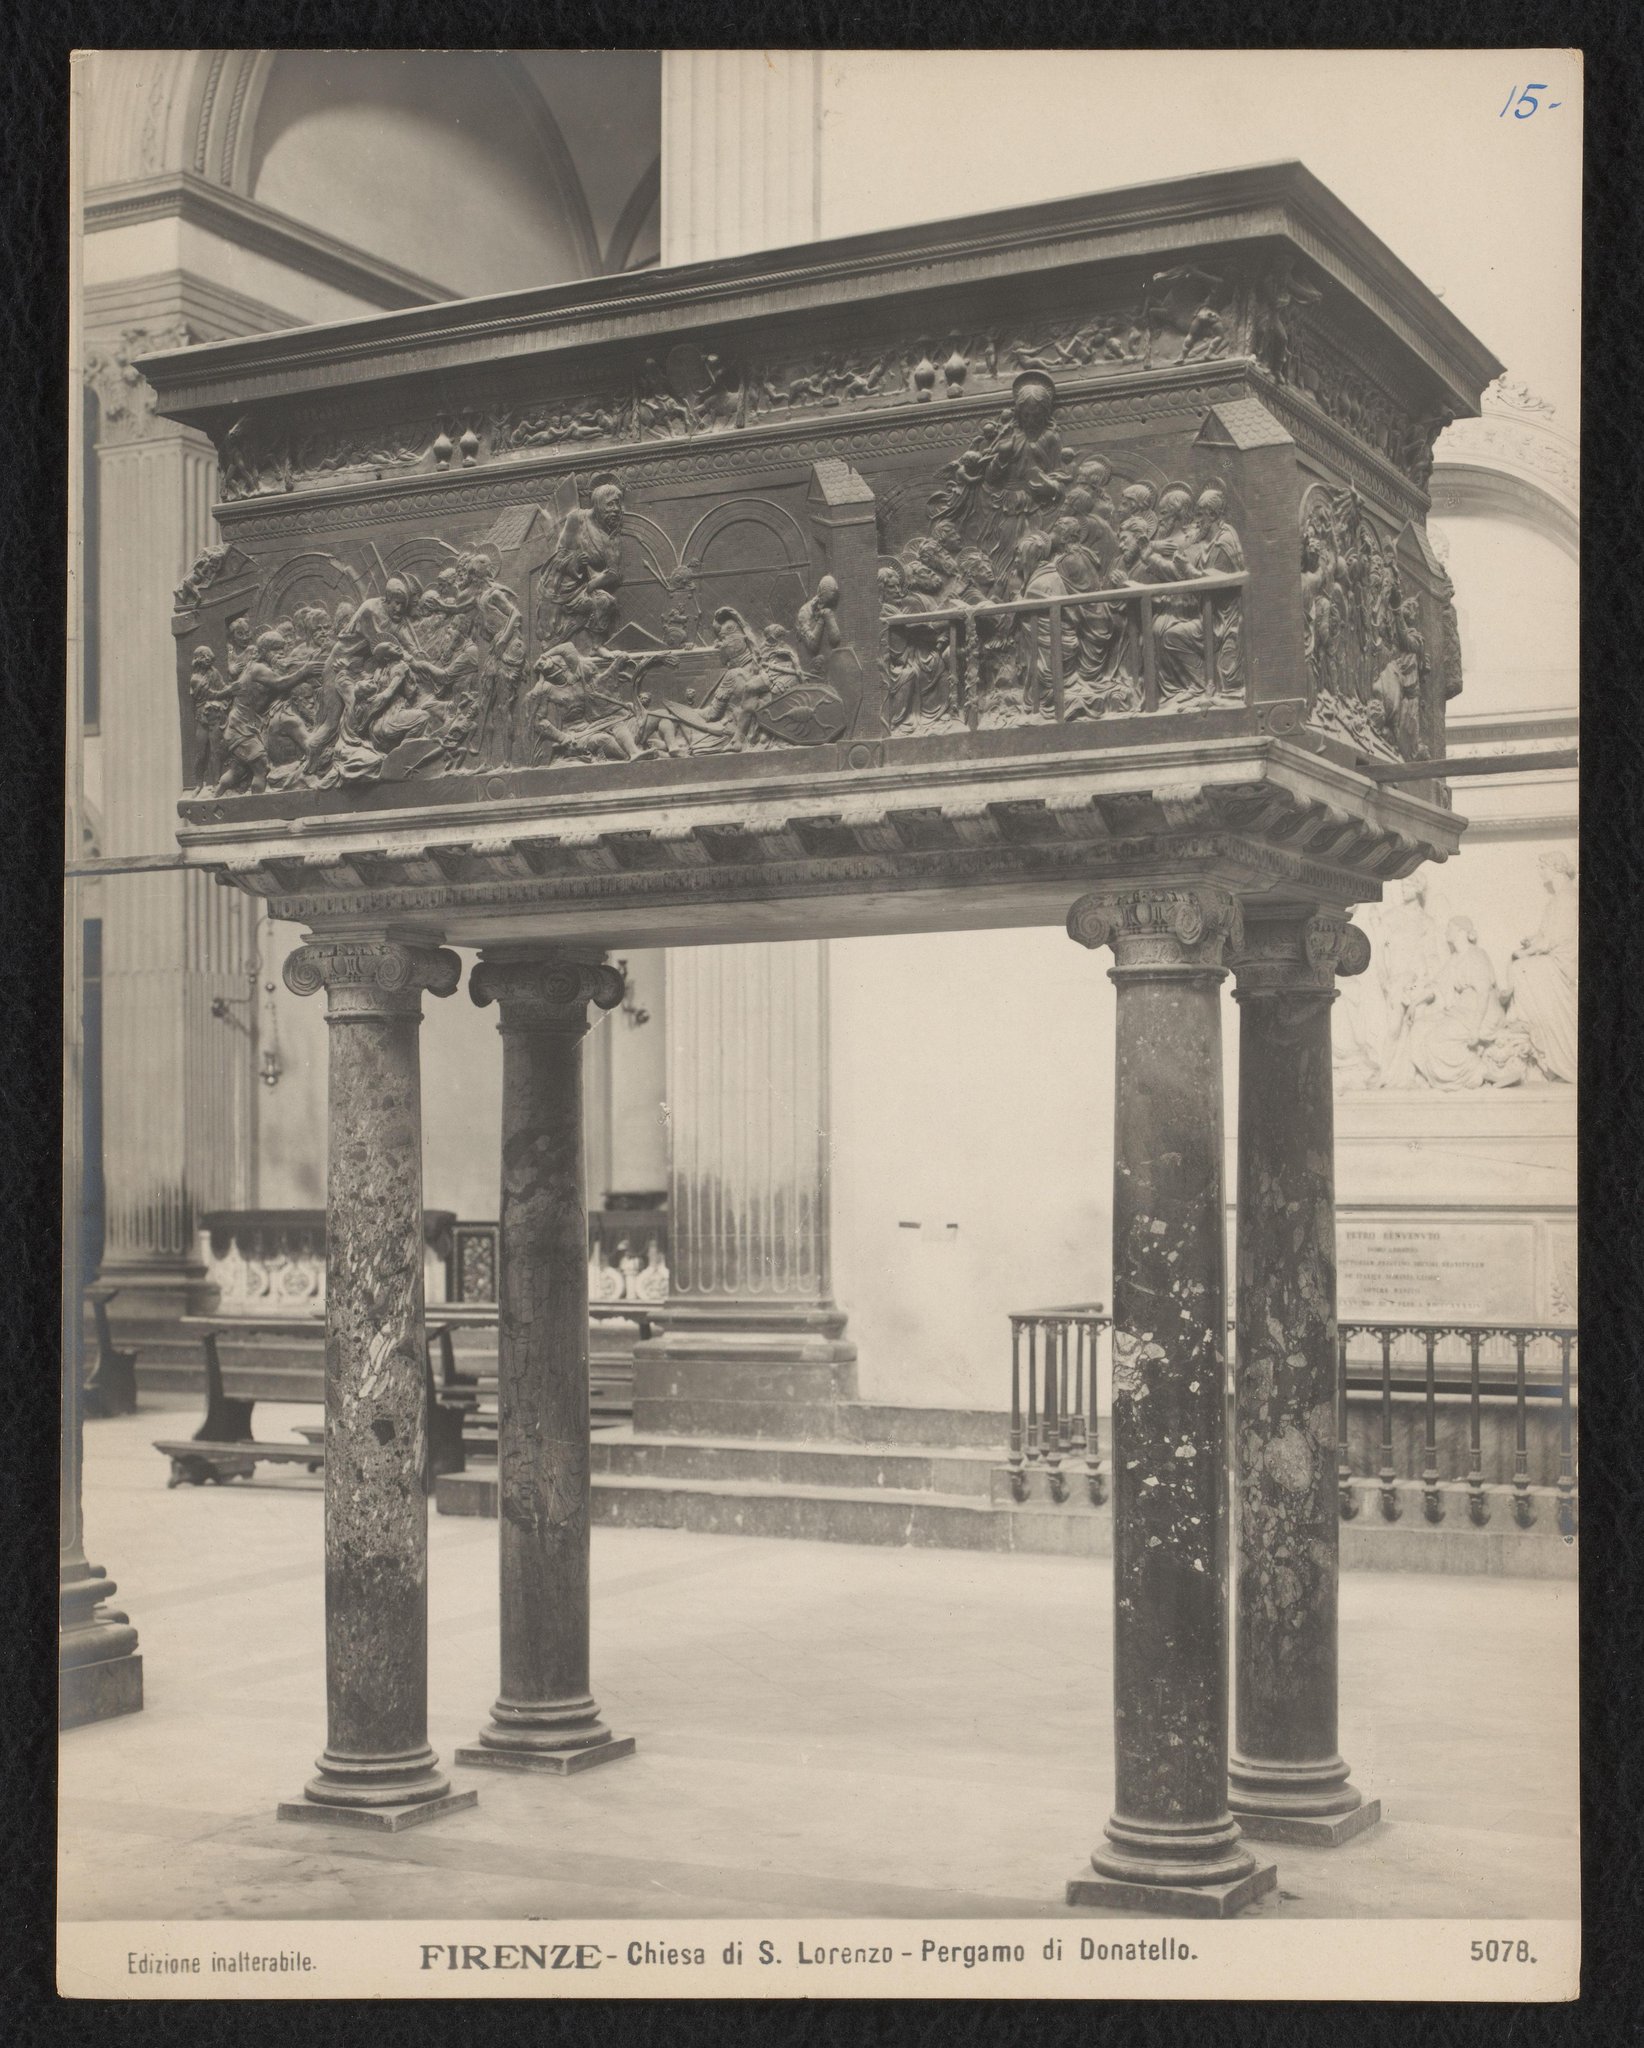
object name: photograph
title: Chiesa di S. Lorenzo - Pergamo di Donatello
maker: Anonymous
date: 1900-1920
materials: paper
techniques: gelatin silver print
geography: florence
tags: interior of church, pulpit, ambo, chancel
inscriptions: number: ‘5078.’, number: ‘15.’, inscription: ‘Edizione inalterabile.’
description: Deze foto maakt deel uit van een omslag.